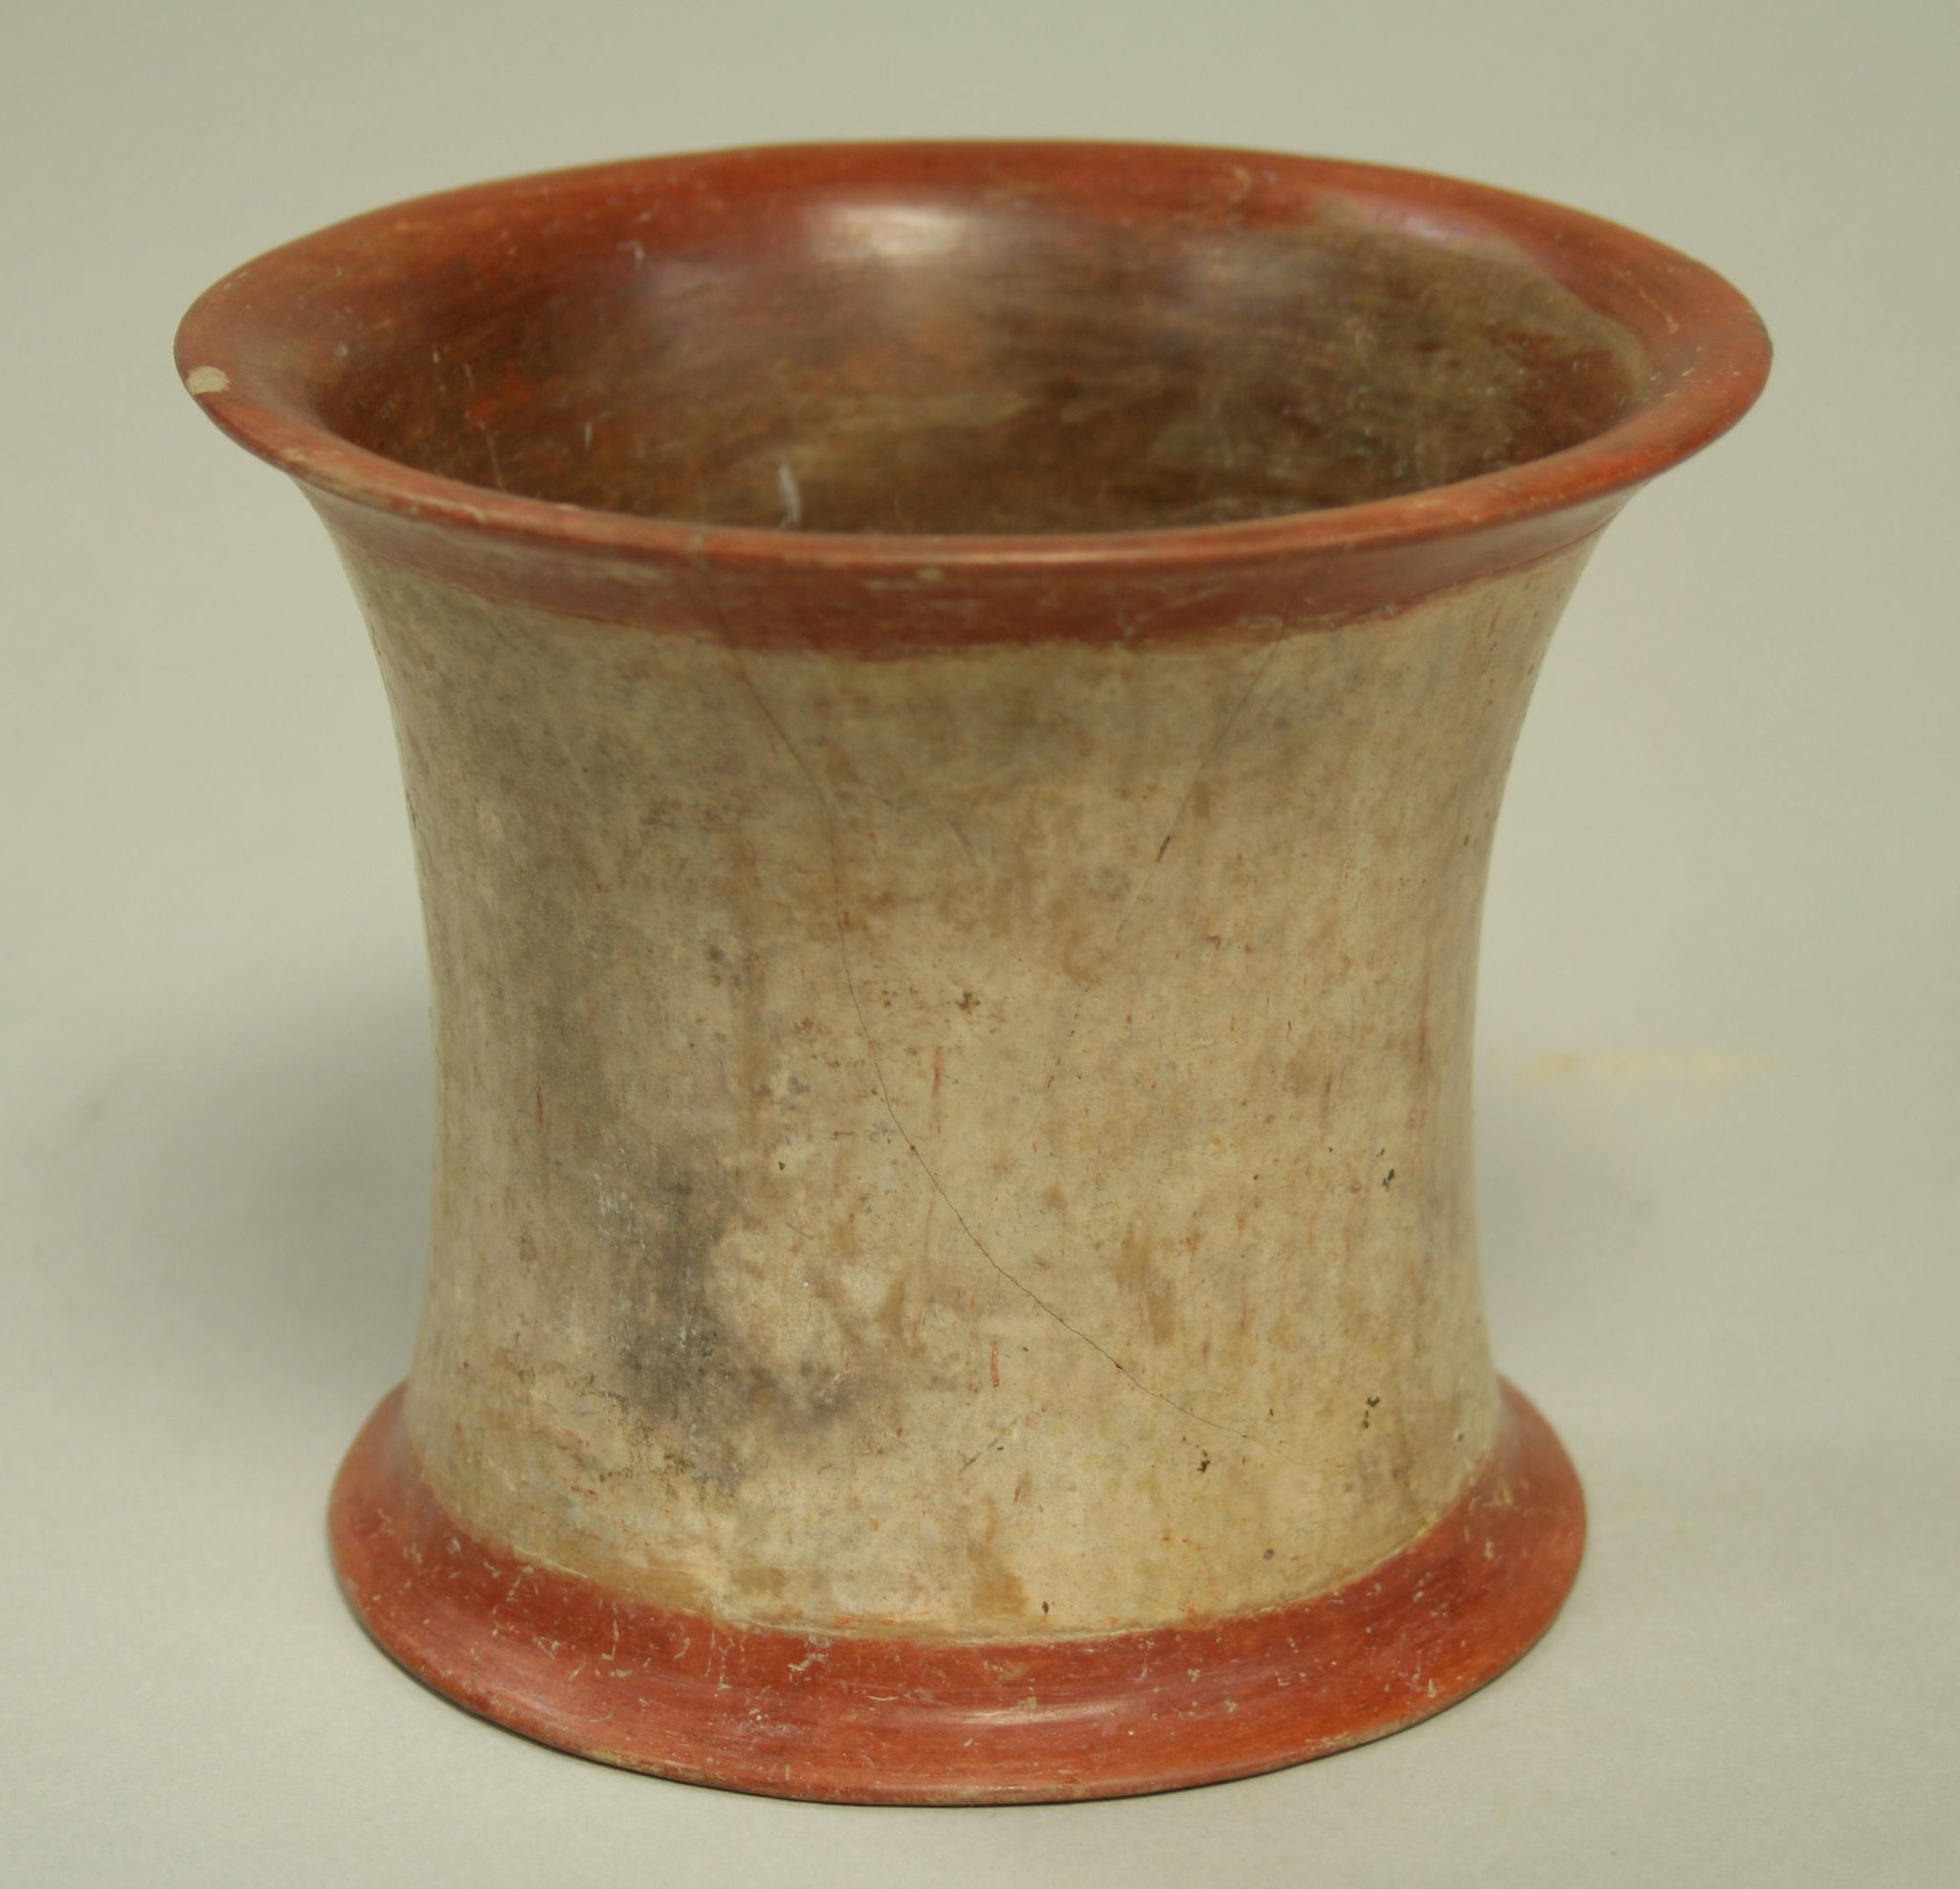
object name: vessel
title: Ceramic Vessel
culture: chorrera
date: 1200-301 BCE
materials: ceramic, pigment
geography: ecuador